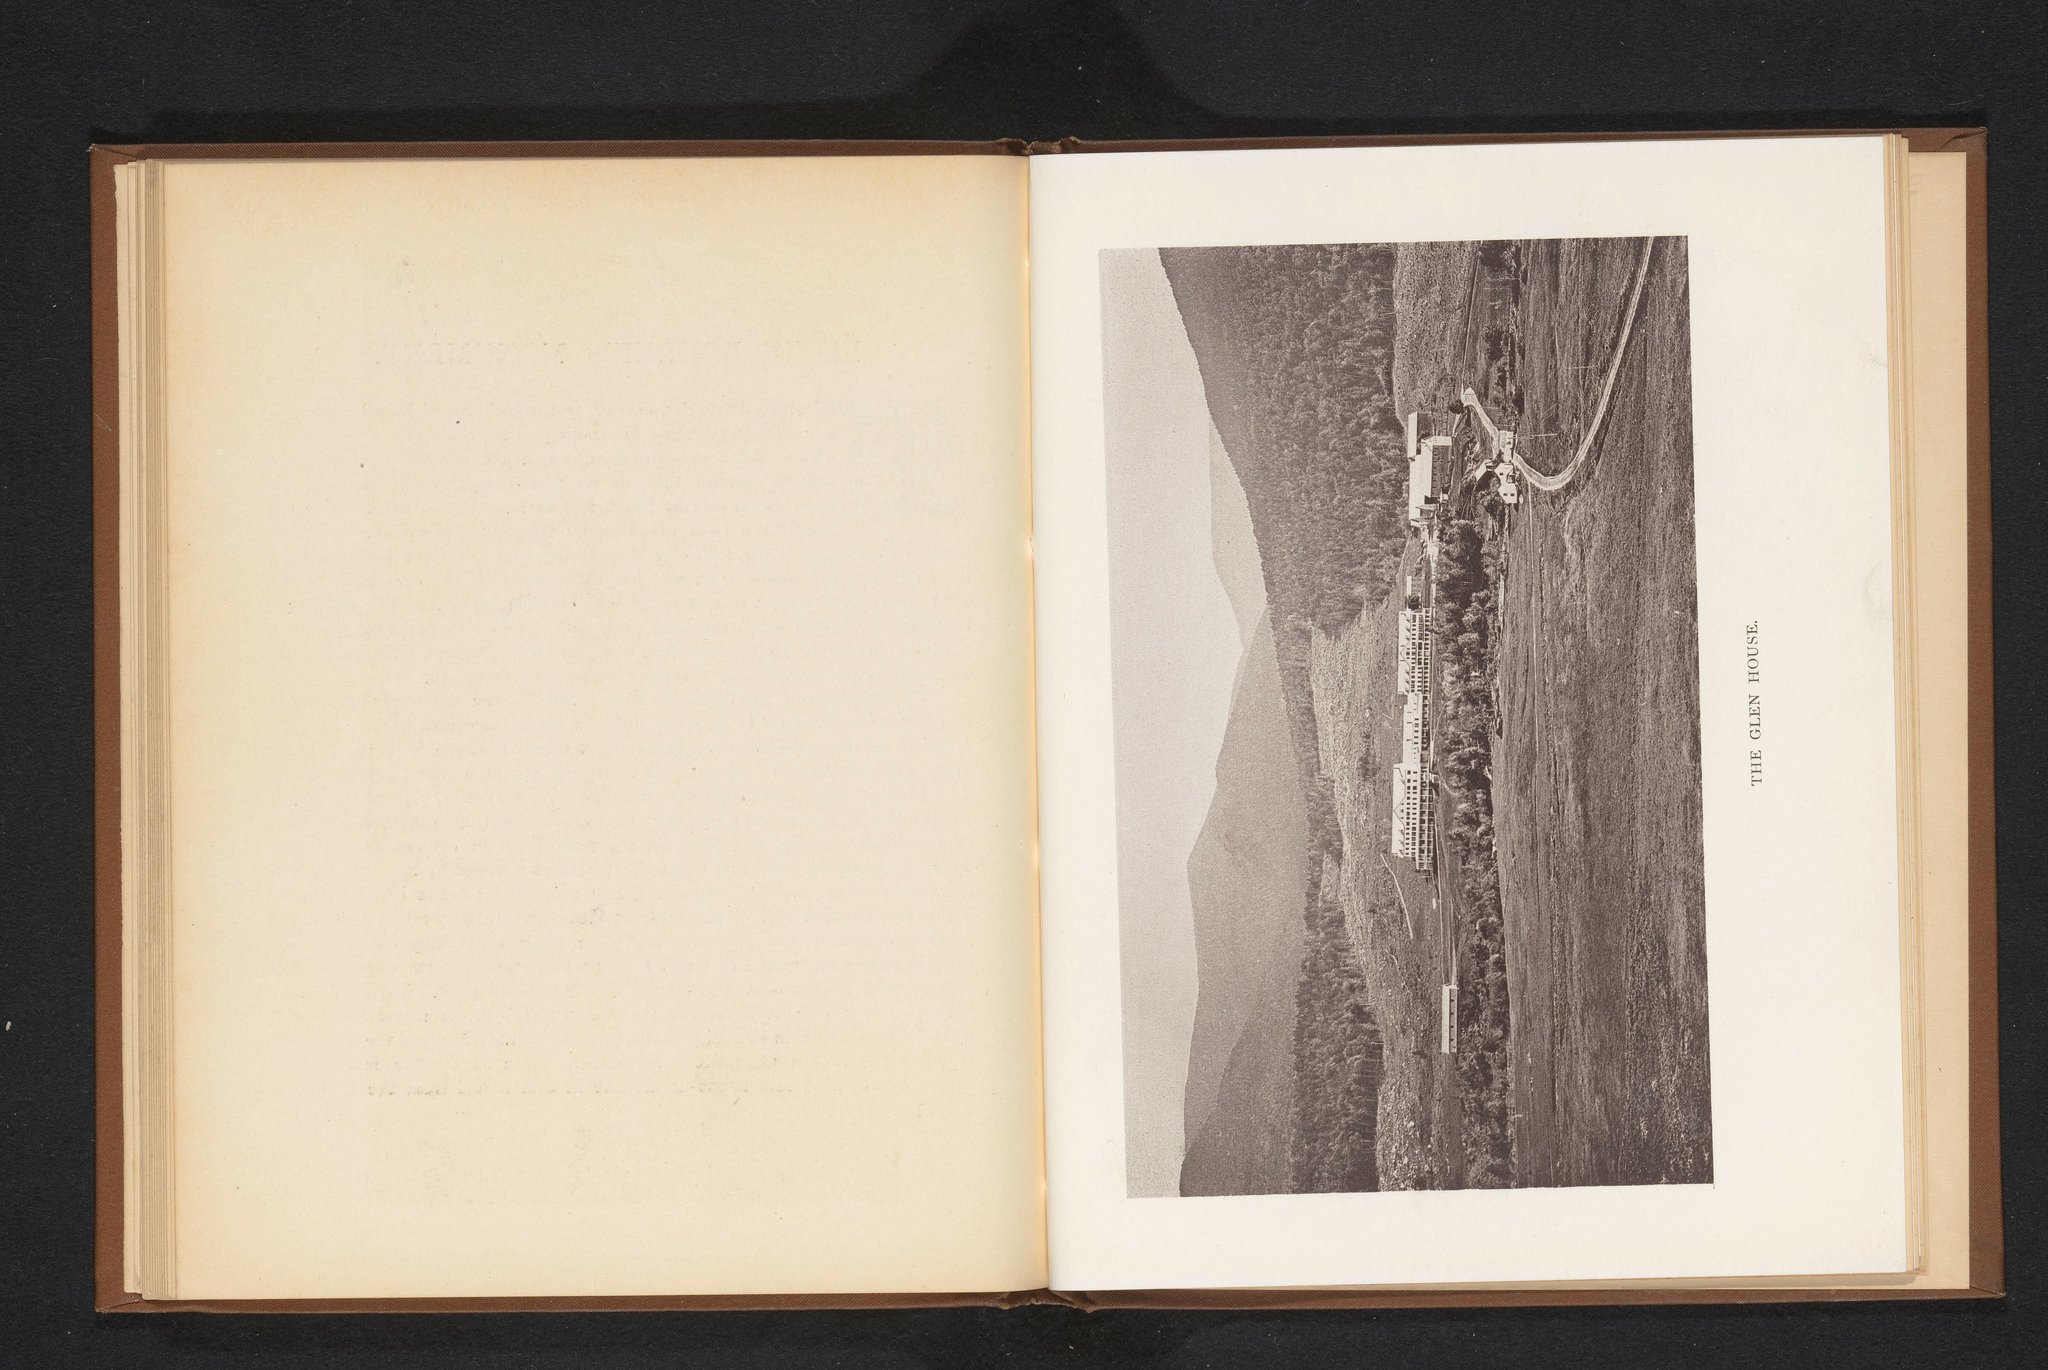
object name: photomechanical print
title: Gezicht op het Glen House in de White Mountains, New Hampshire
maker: Anonymous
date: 1874-1879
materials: paper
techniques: photograph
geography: white mountains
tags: hotel, hostelry, inn, mountains